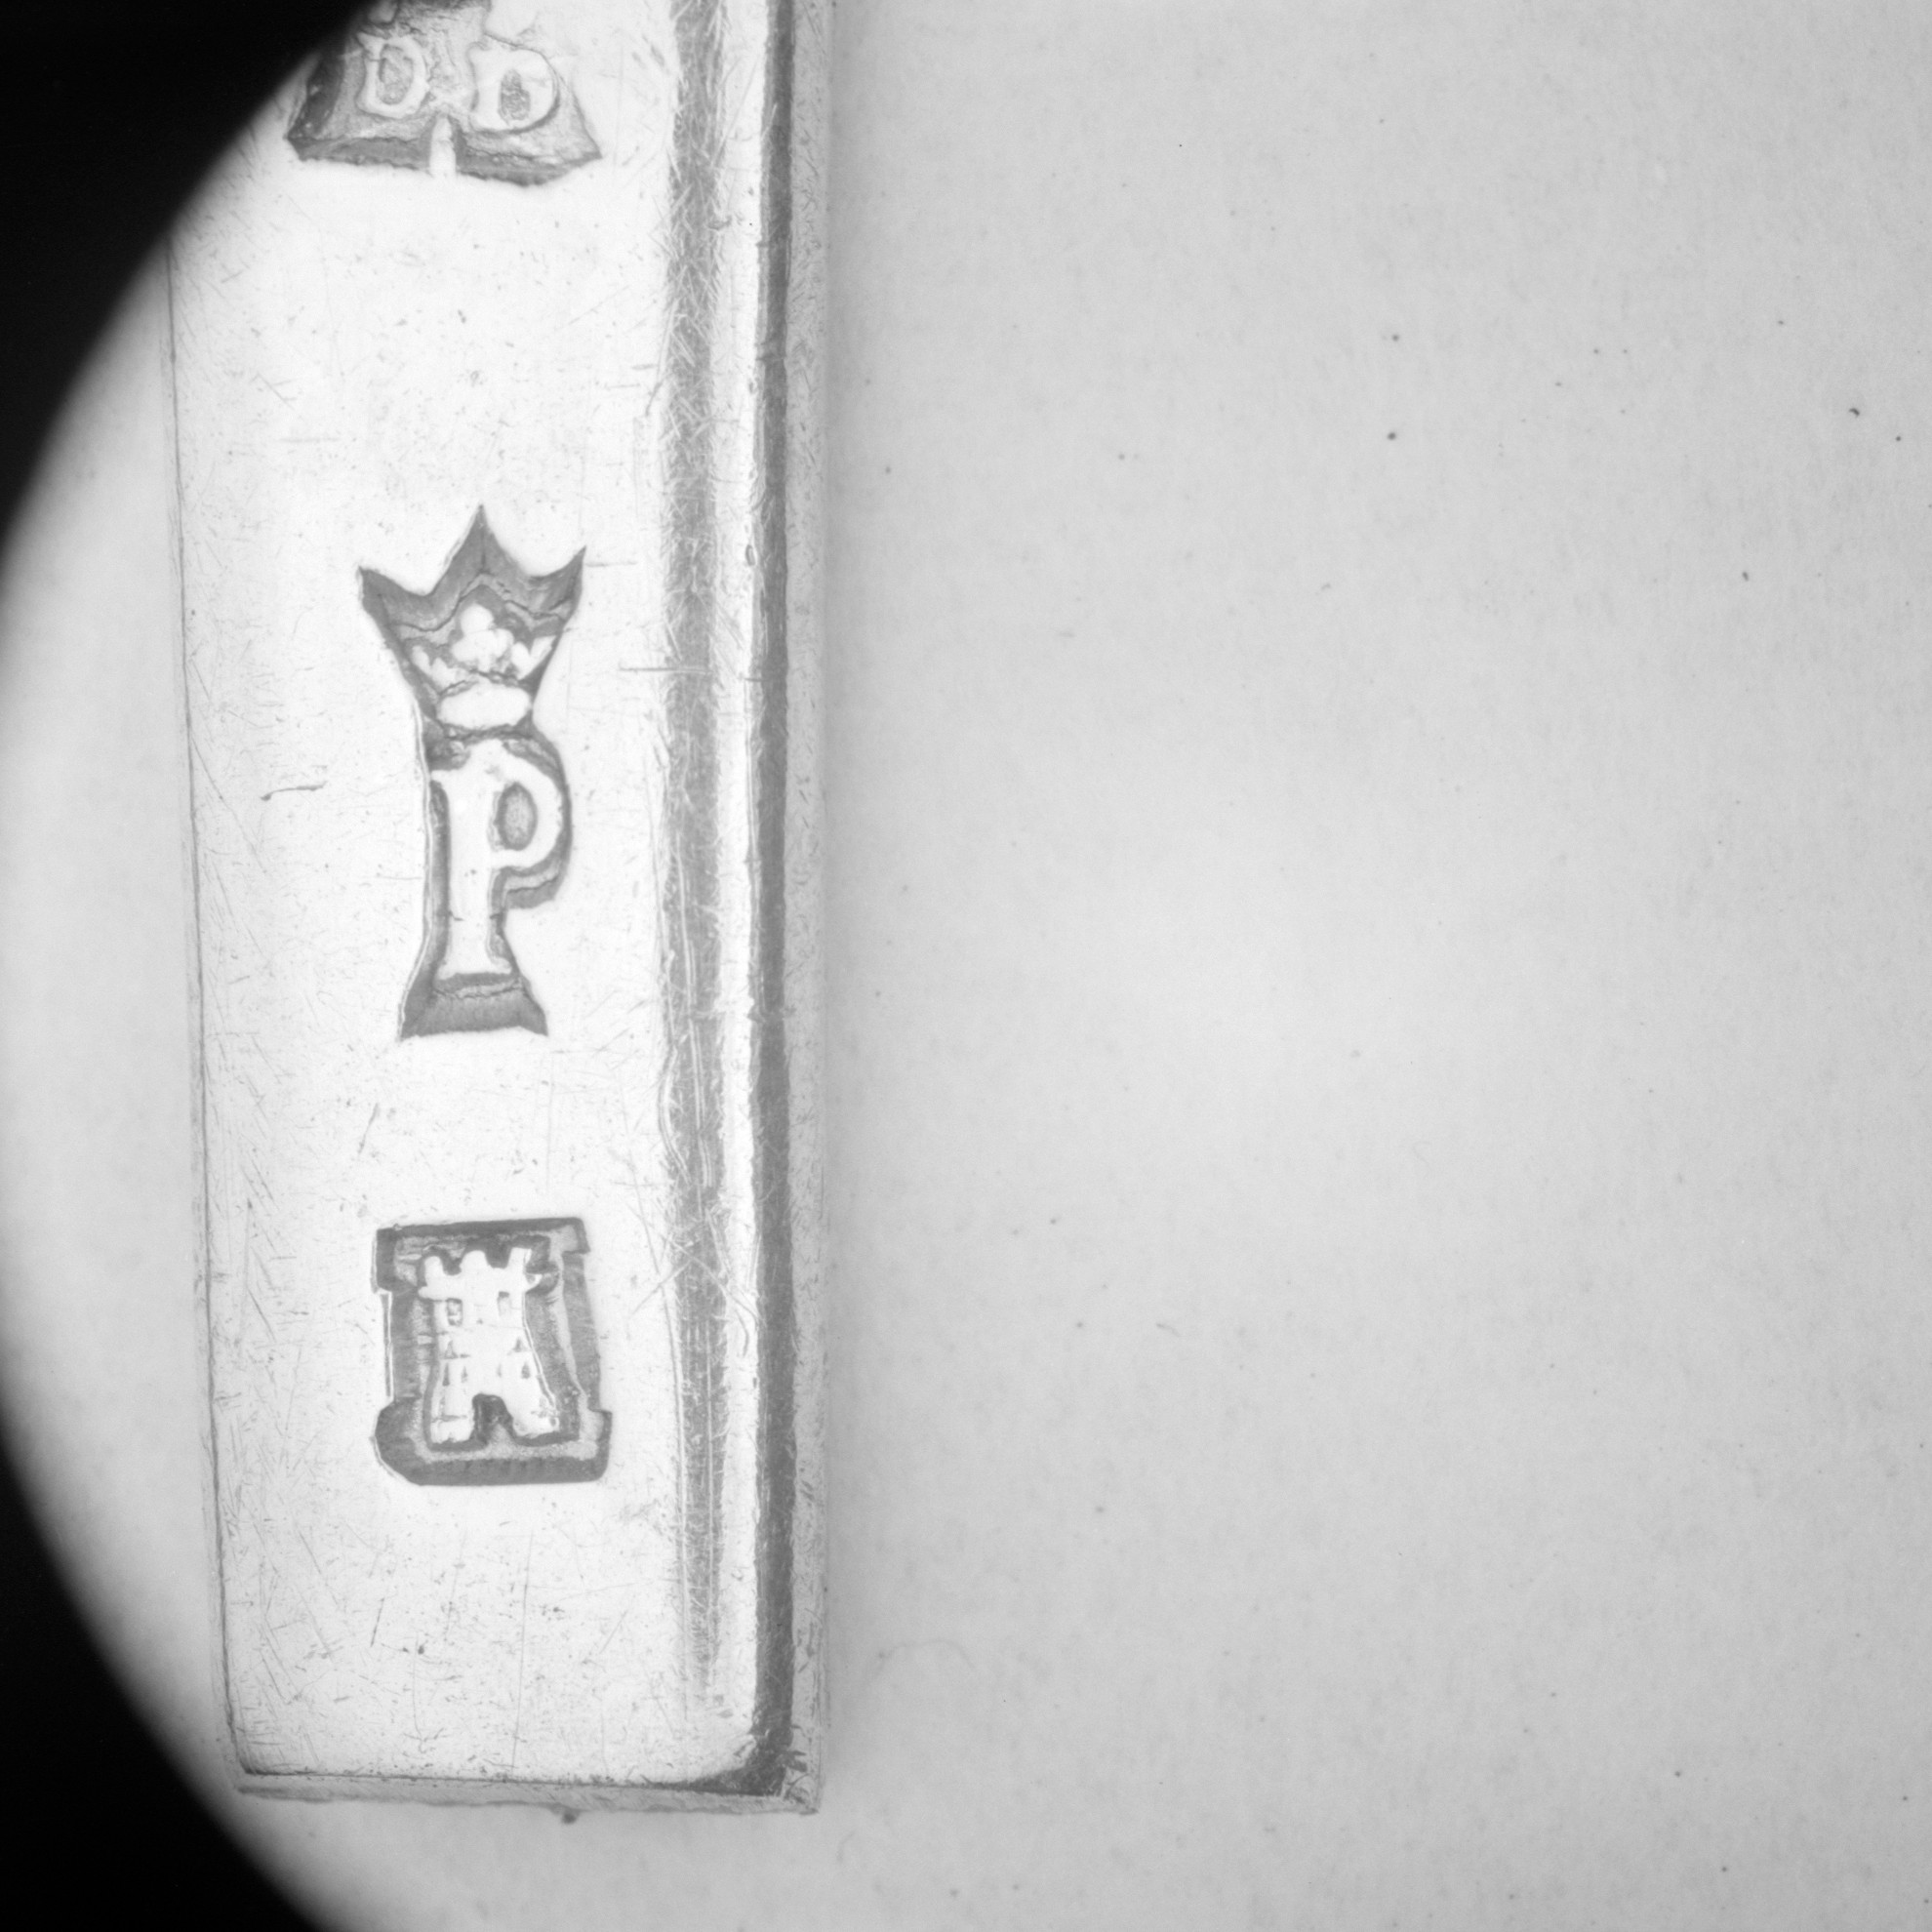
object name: spoon handle section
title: Section of a spoon handle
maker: daniel-toussaint desmares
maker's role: maker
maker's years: 1715-1815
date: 1774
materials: silver